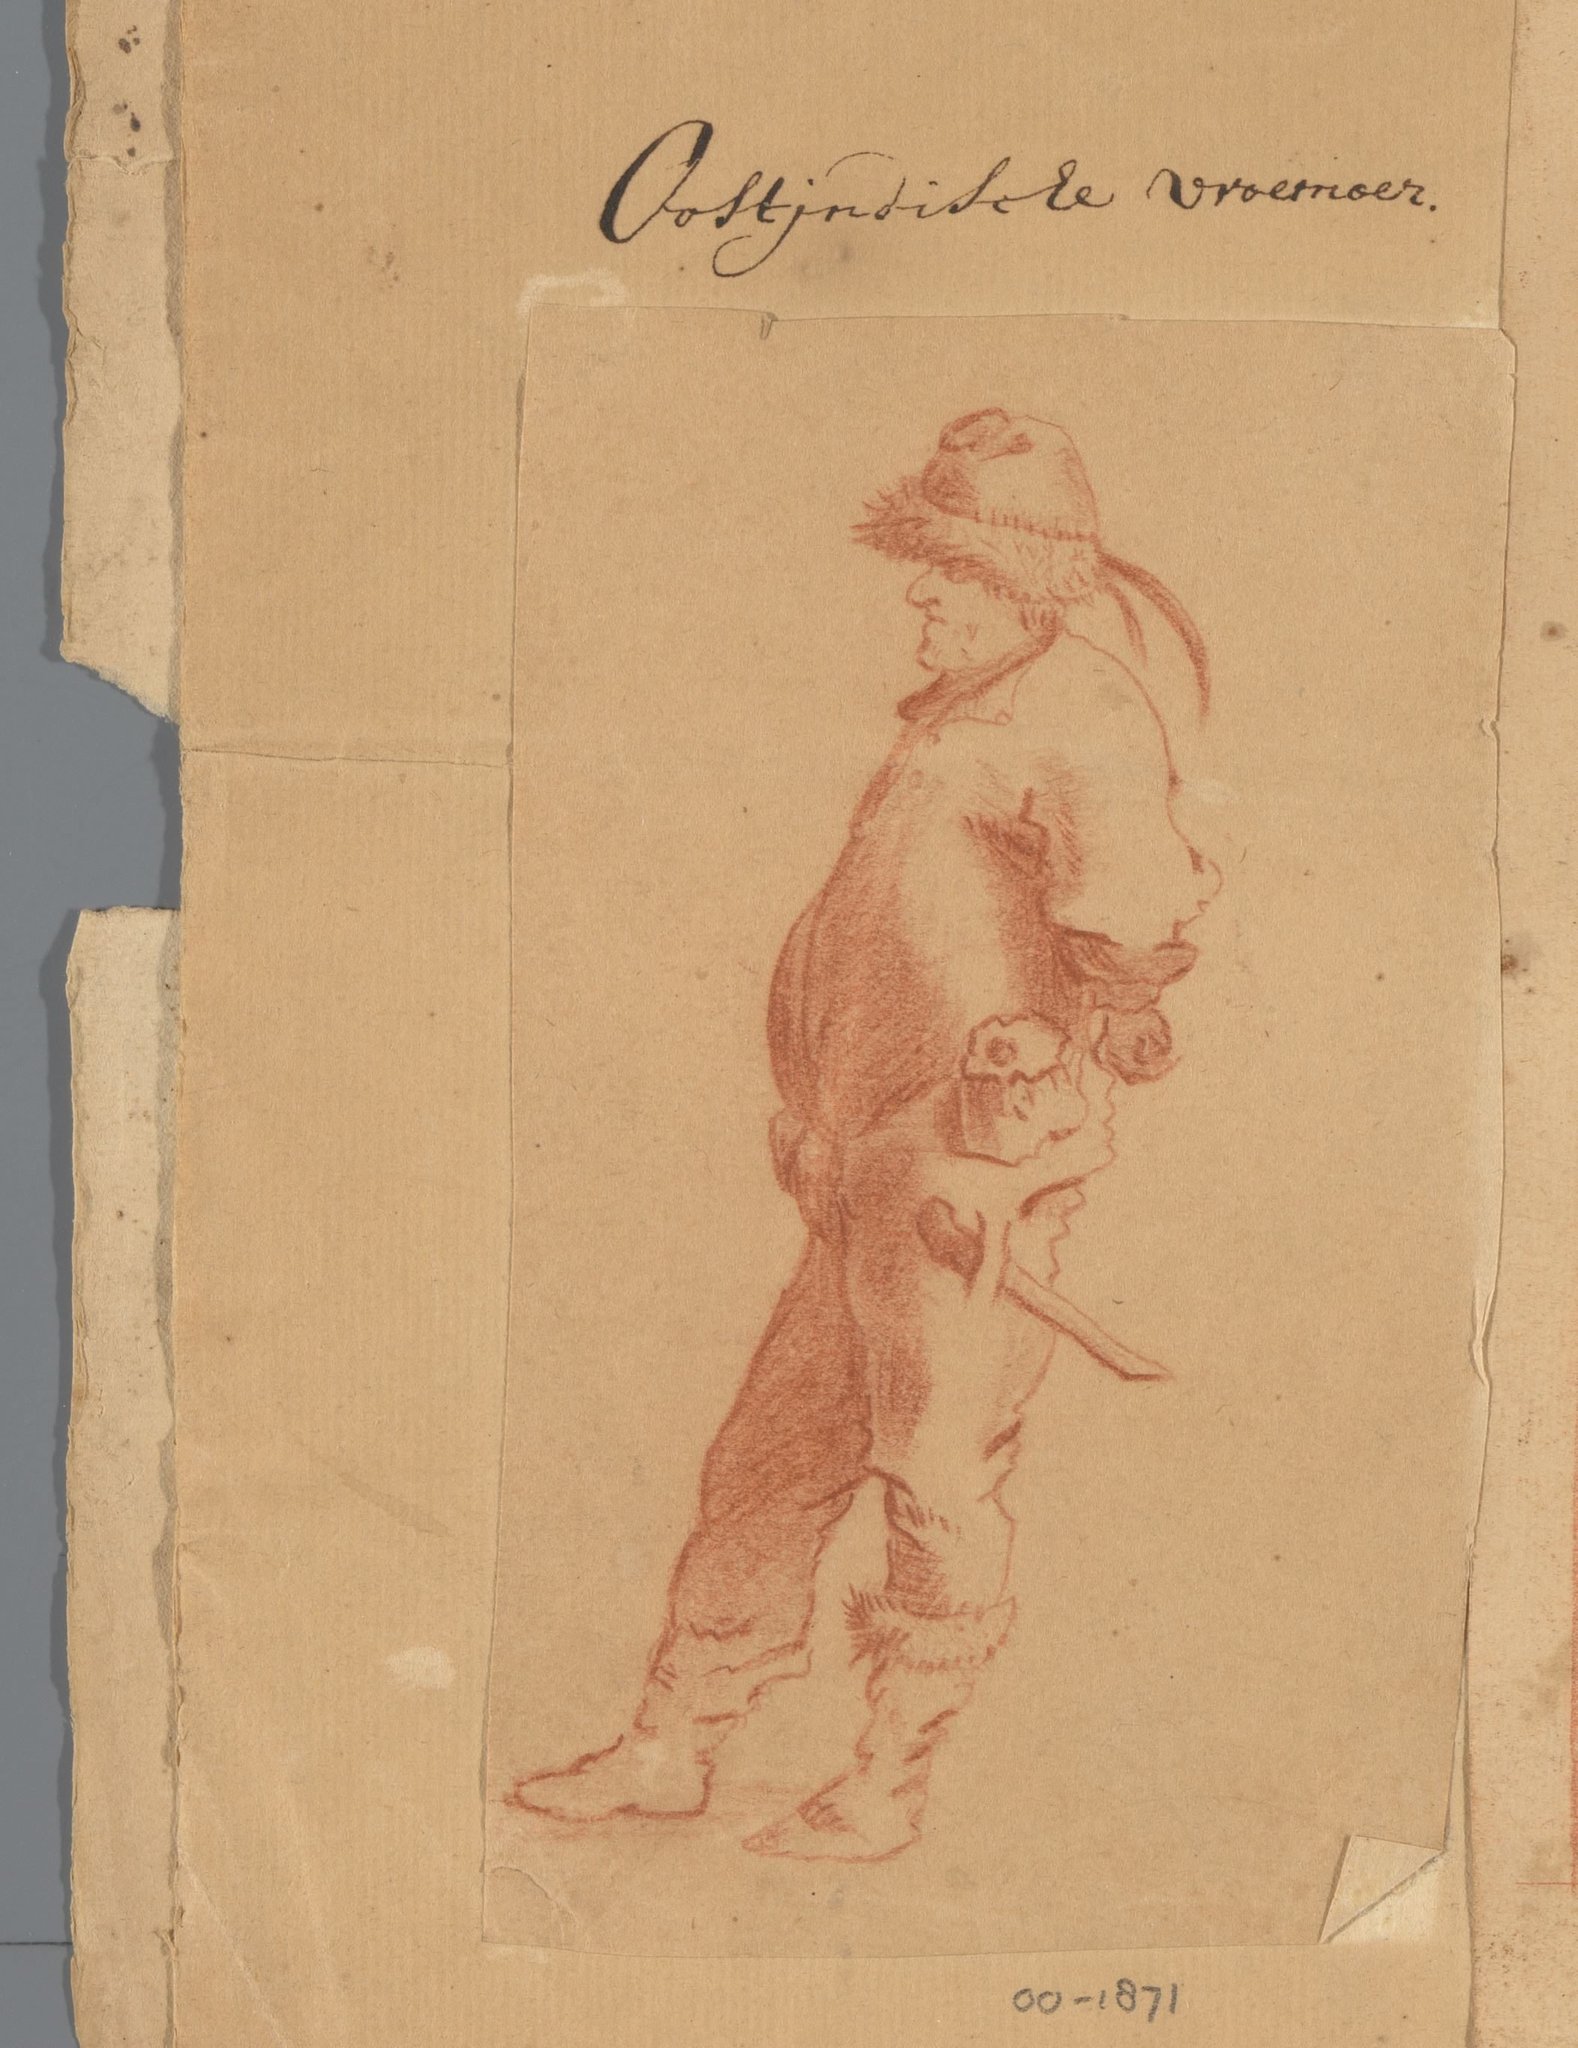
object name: drawing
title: Oostindische vroesnoer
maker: Anonymous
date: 1700-1800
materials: chalk, paper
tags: buffoon (in general) (german: 'schalksnarr')